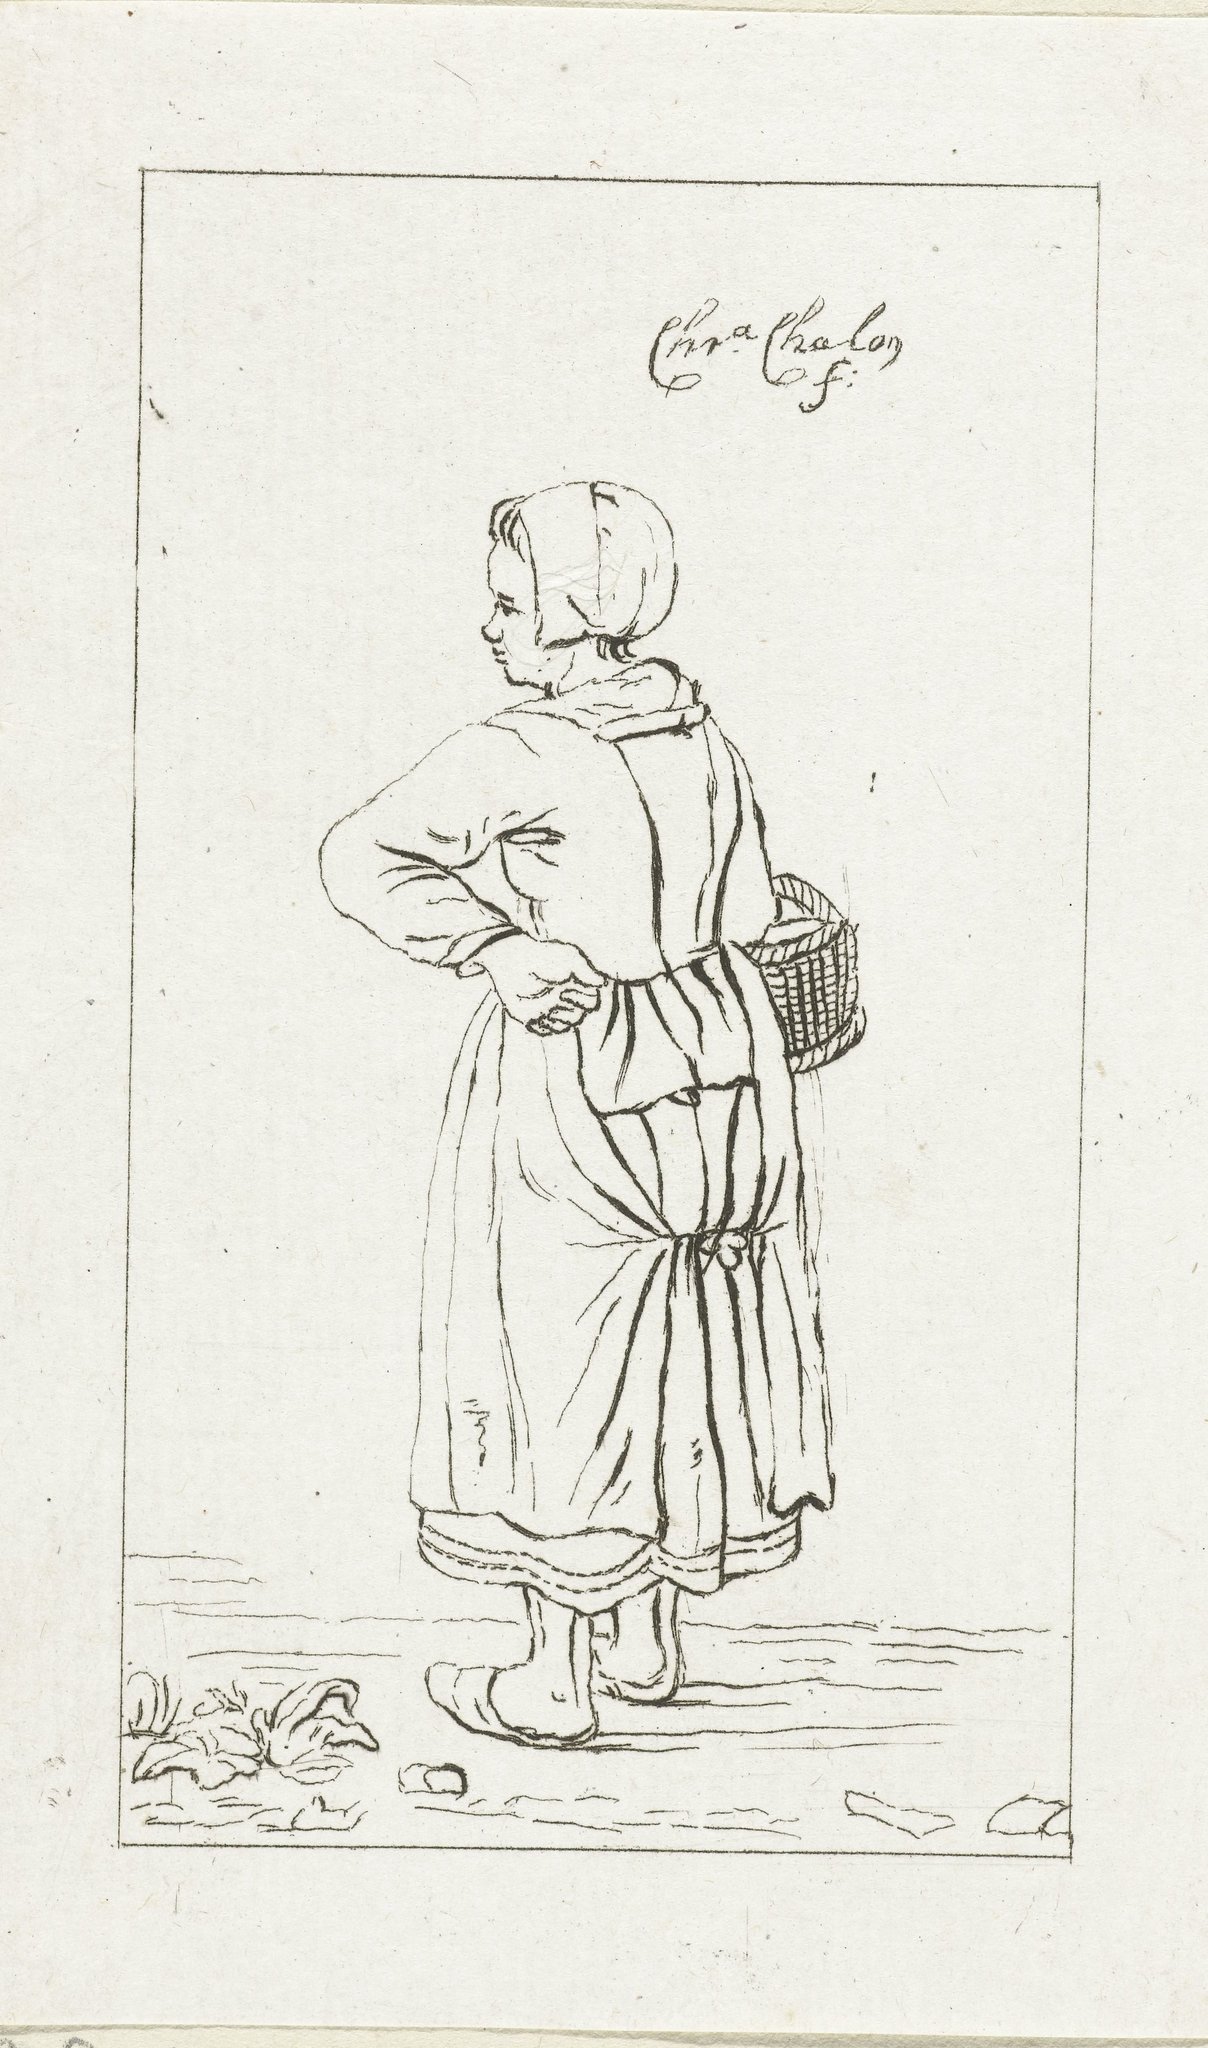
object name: print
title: Vrouw met mand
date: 1779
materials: paper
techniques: etching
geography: leiden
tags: carrying something in basket, bag, rucksack, etc., the (nude) human figure; 'corpo humano' (ripa) (+ young female (human being))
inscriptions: collector's mark: Lugt 2228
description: Een jonge vrouw met een mandje aan haar rechterarm en een hand in haar zij, schuin van achteren gezien.